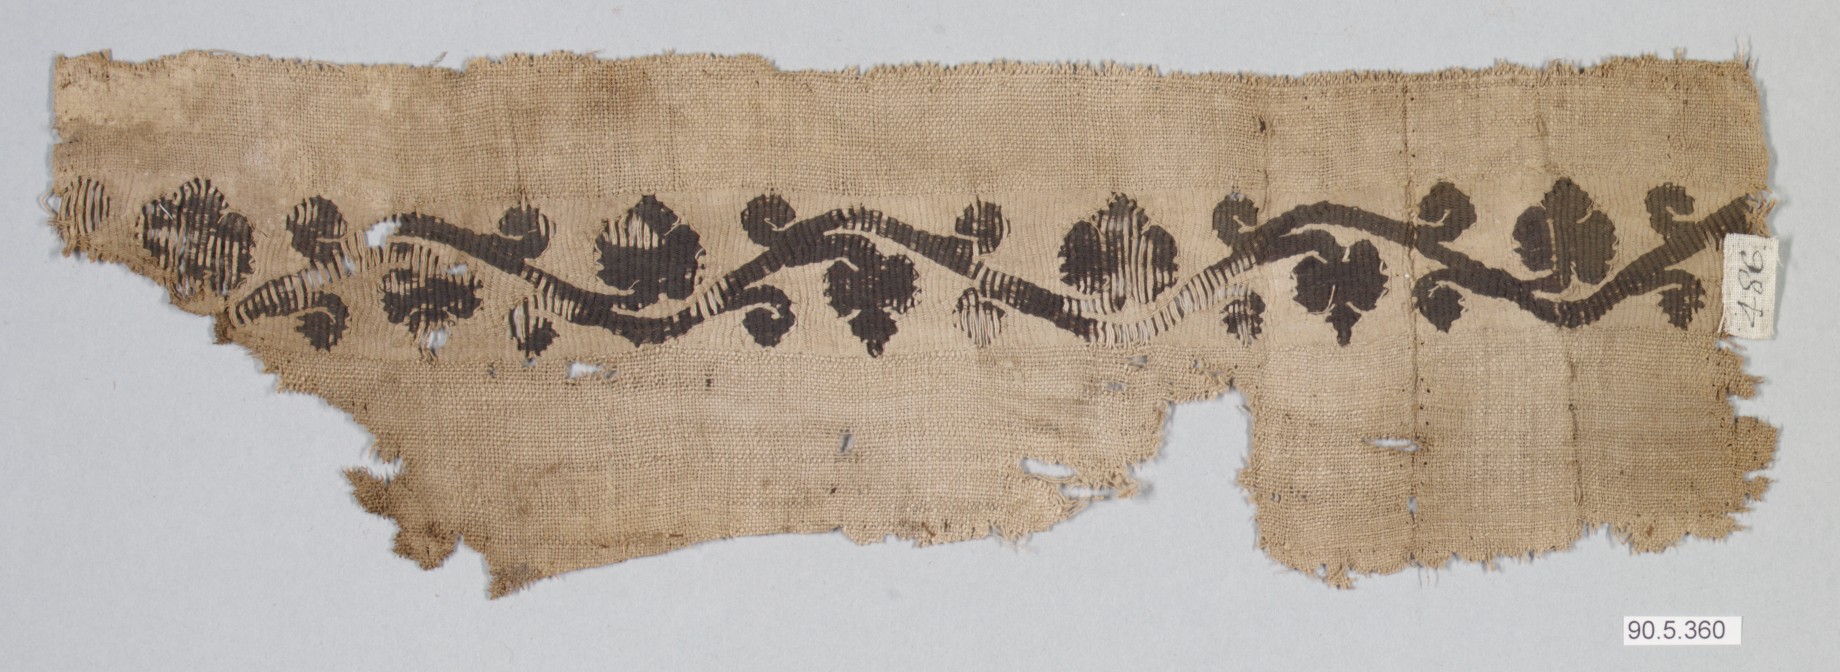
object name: textile fragment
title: Fragment of a Tunic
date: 201-400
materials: linen, wool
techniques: weave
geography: egypt